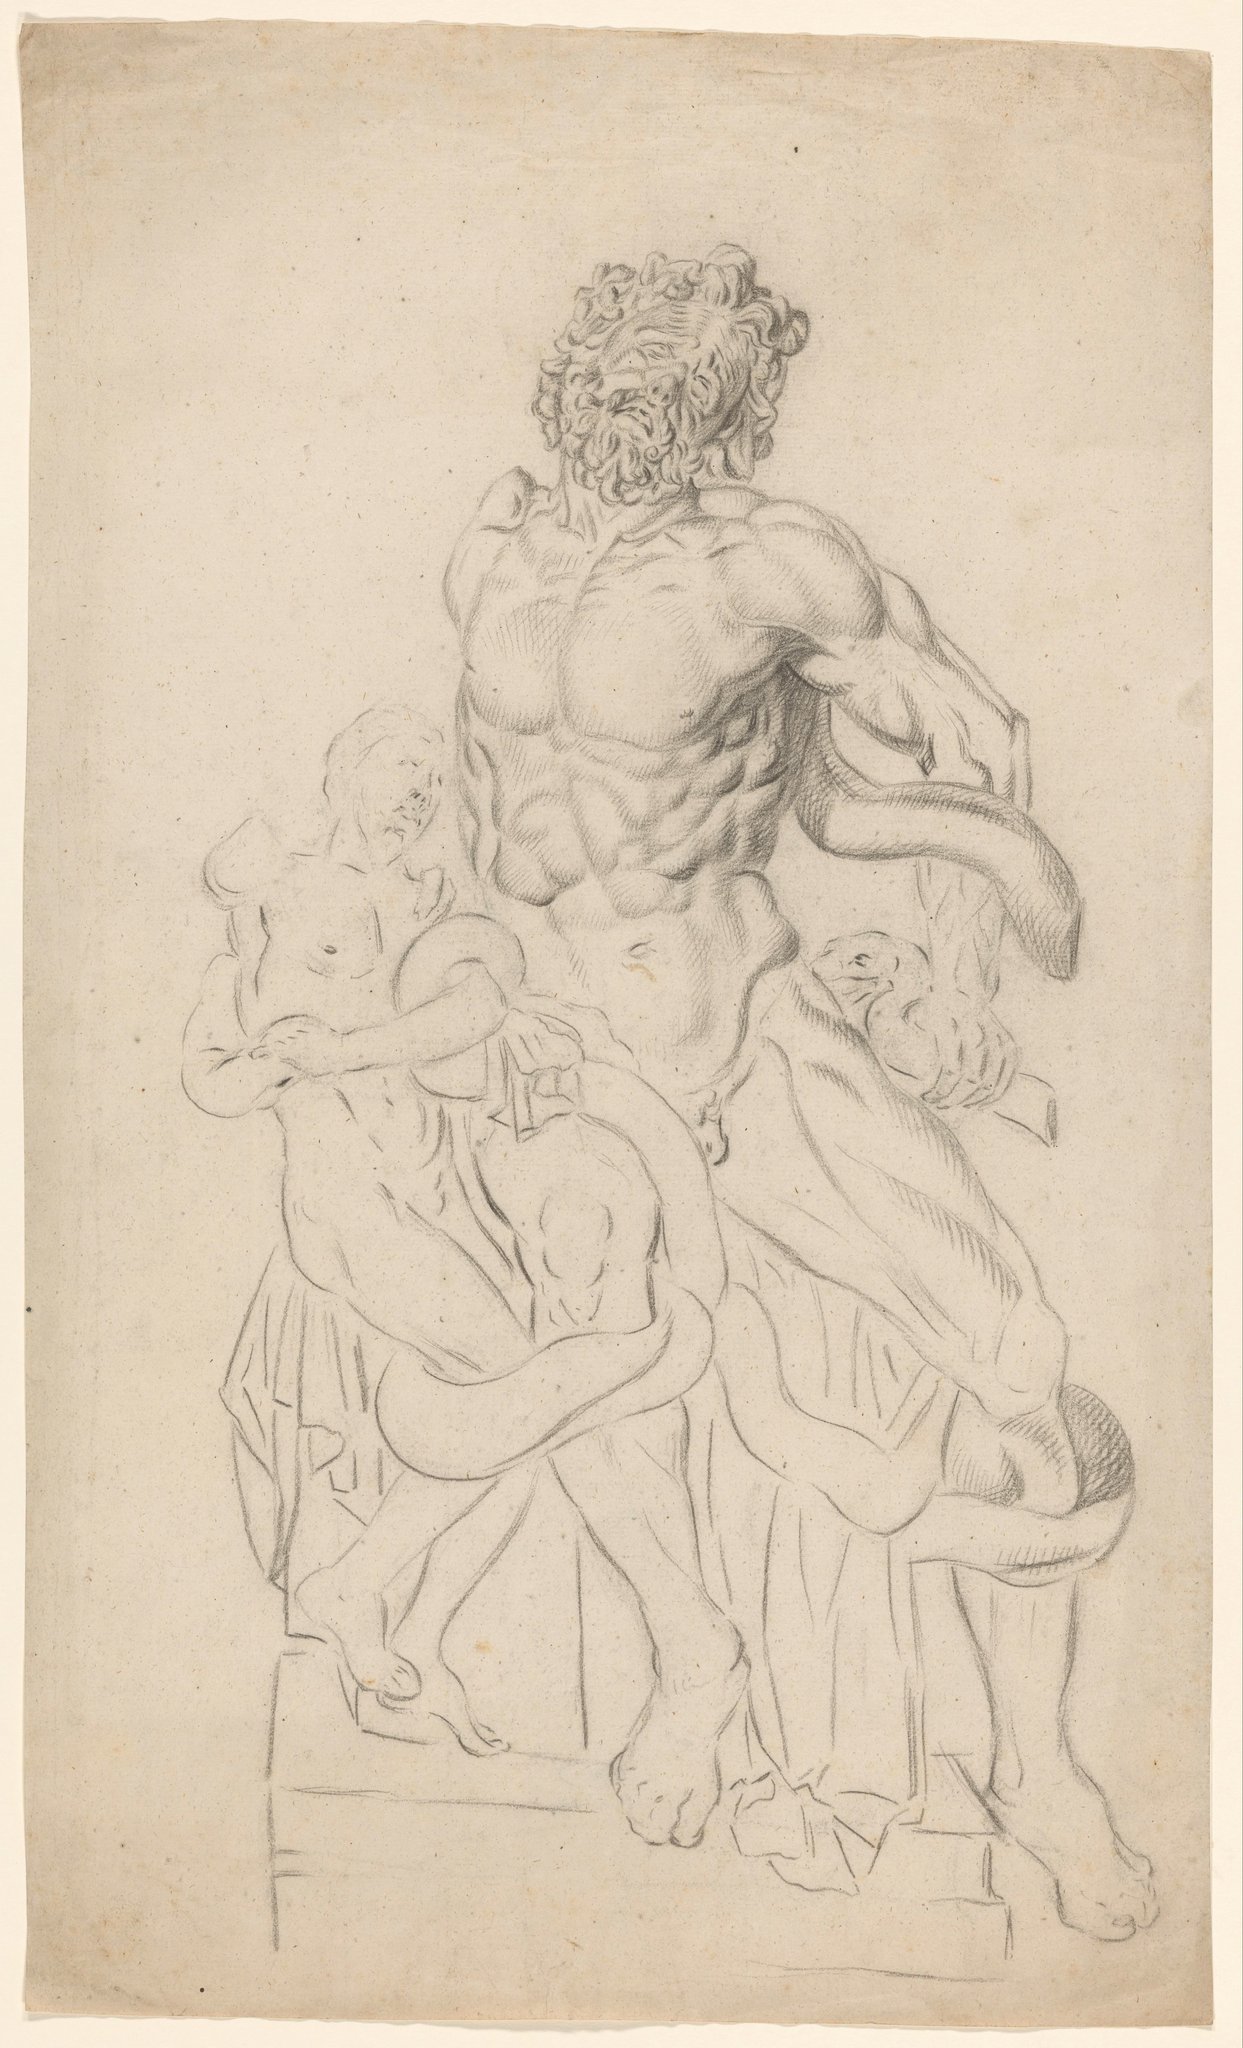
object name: figuurstudie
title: Academiestudie naar gips van Laocoön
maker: johannes tavenraat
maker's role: draughtsman, painter, print maker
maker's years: 1809-1881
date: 1819-1881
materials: chalk, paper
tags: names of artefacts and man-made objects (buildings excluded), piece of sculpture, reproduction of a piece of sculpture (+ ceramics ~ arts), laocoon and his twin sons are strangled by two serpents during the preparations for a sacrifice